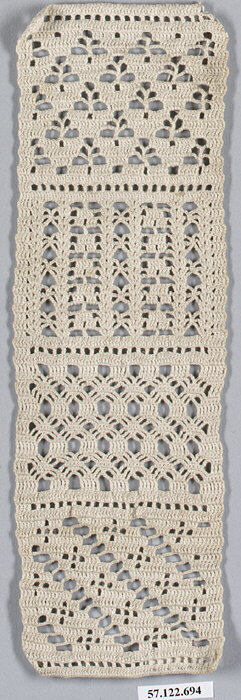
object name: sampler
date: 1801-1900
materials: cotton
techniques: crochet